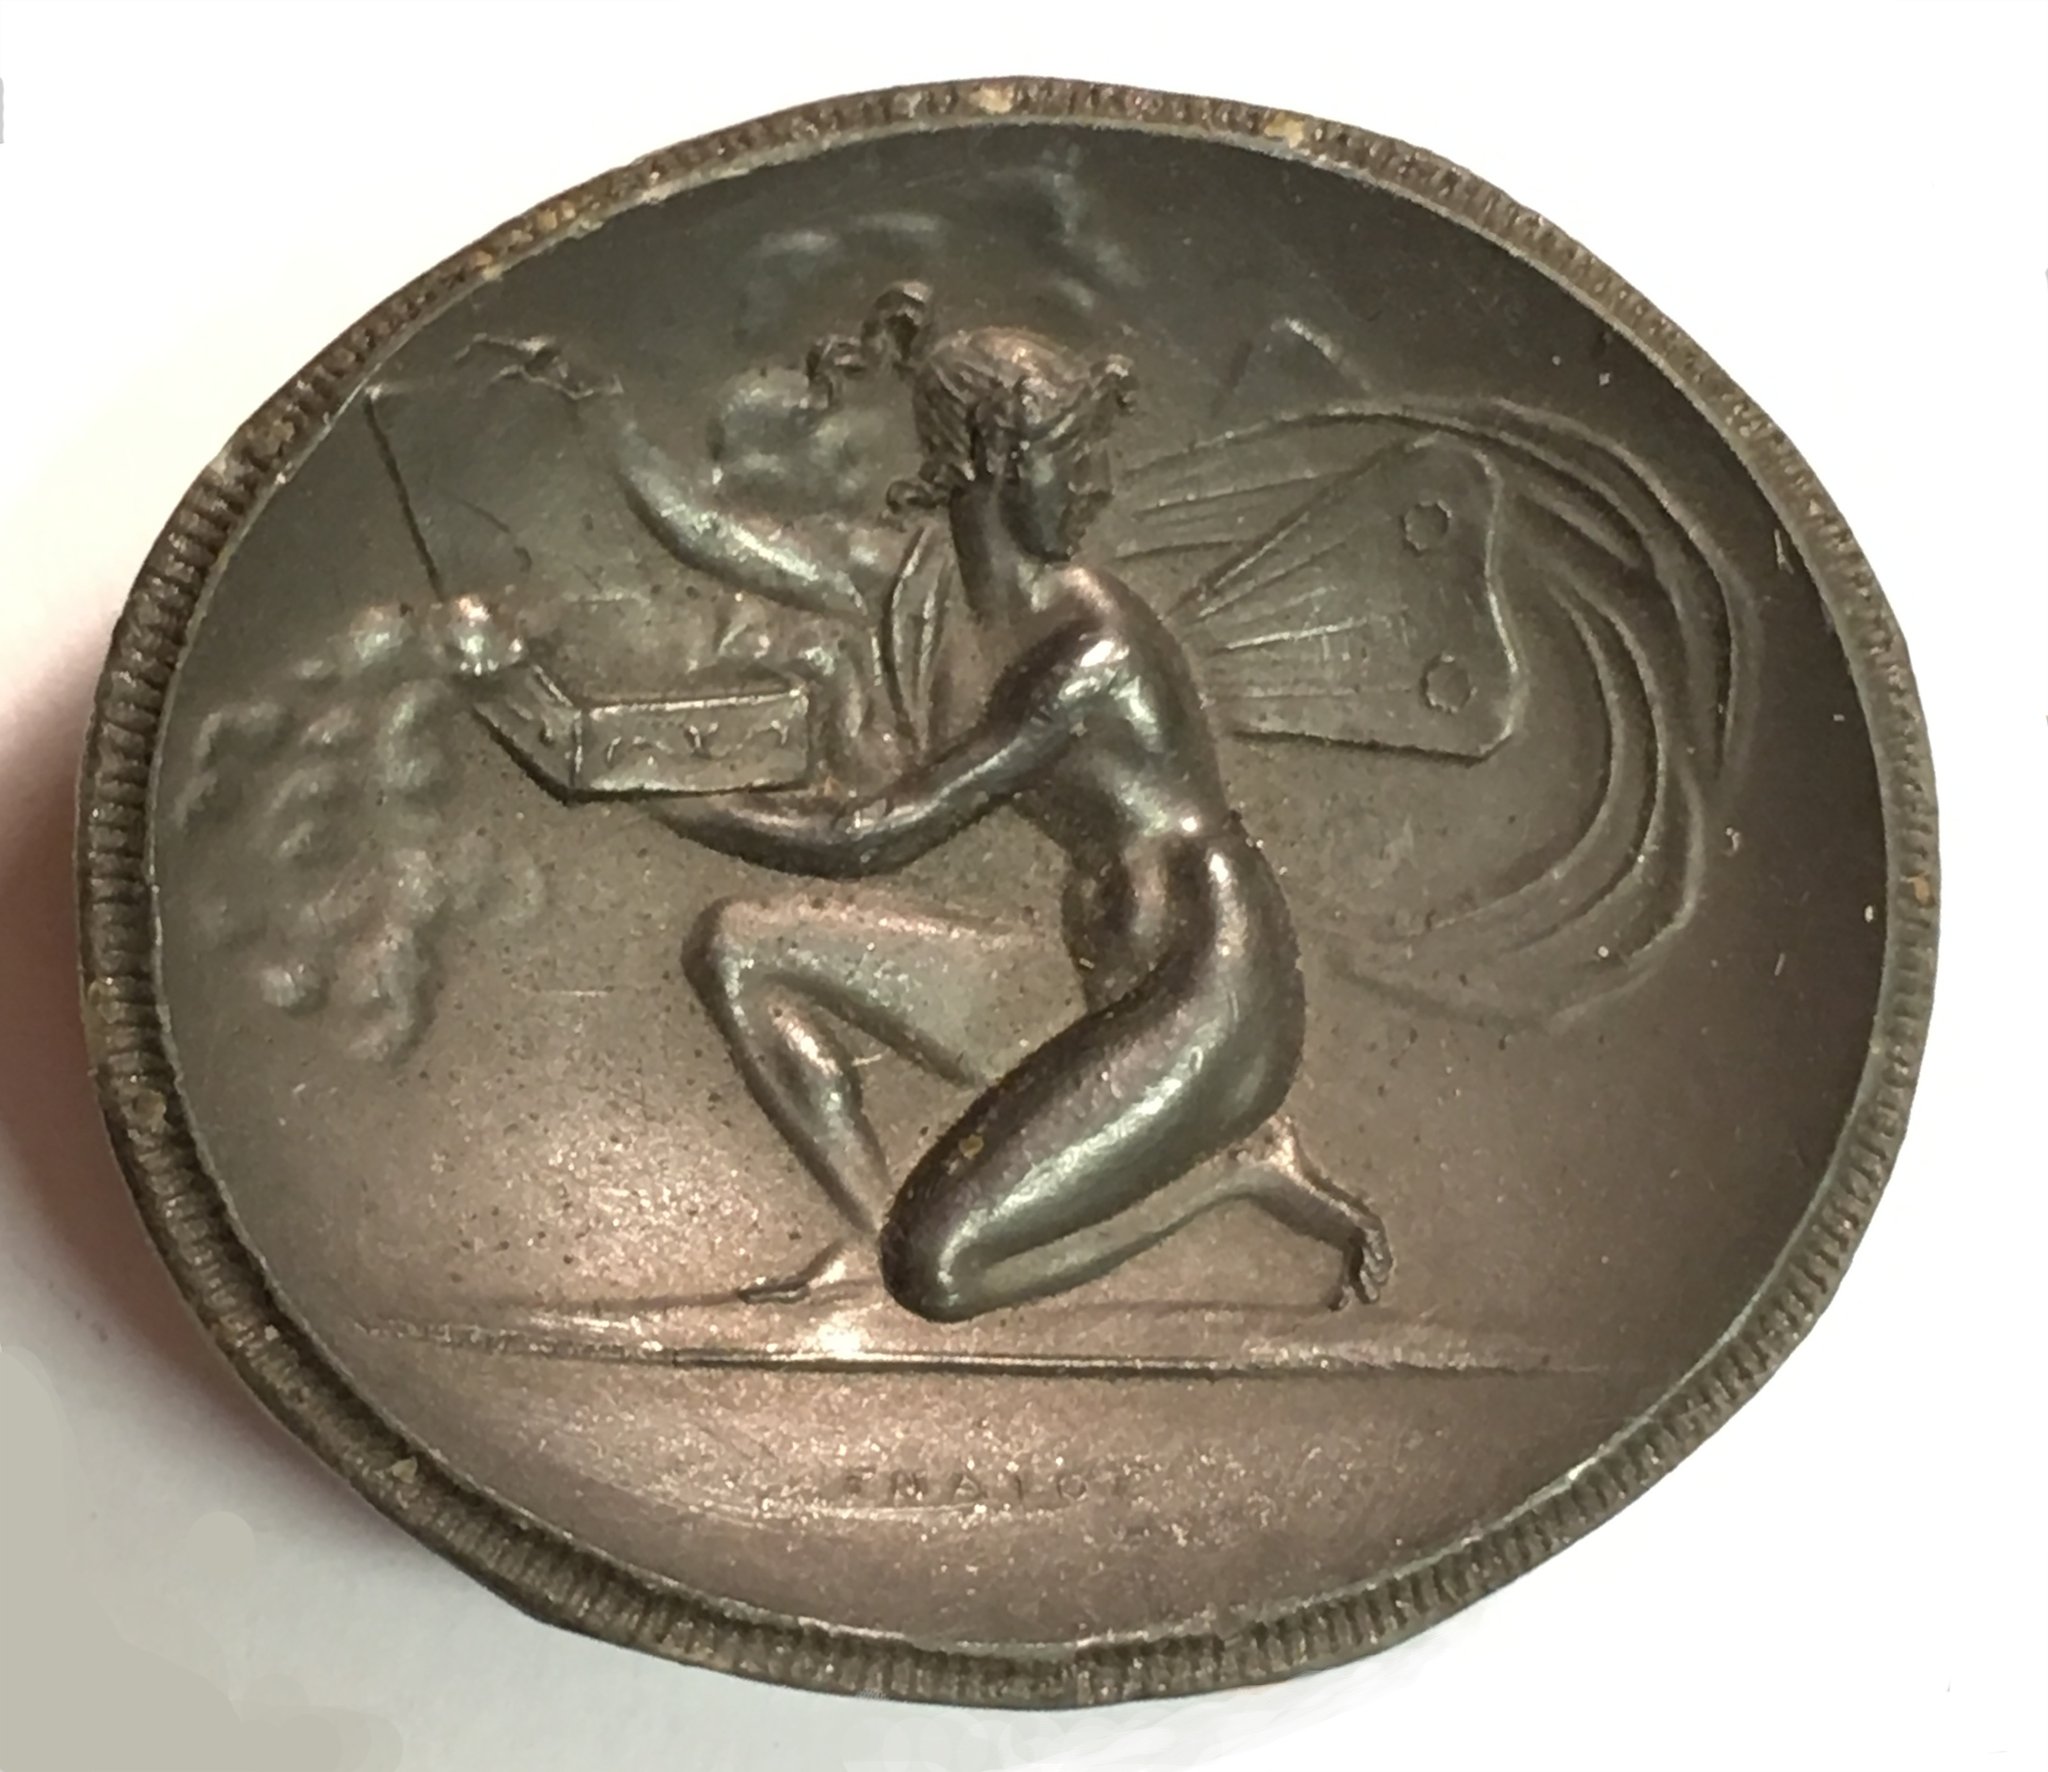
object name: intaglio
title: Amethyst ring stone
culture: post-classical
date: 7000 BCE-330 CE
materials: gemstone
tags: psyche